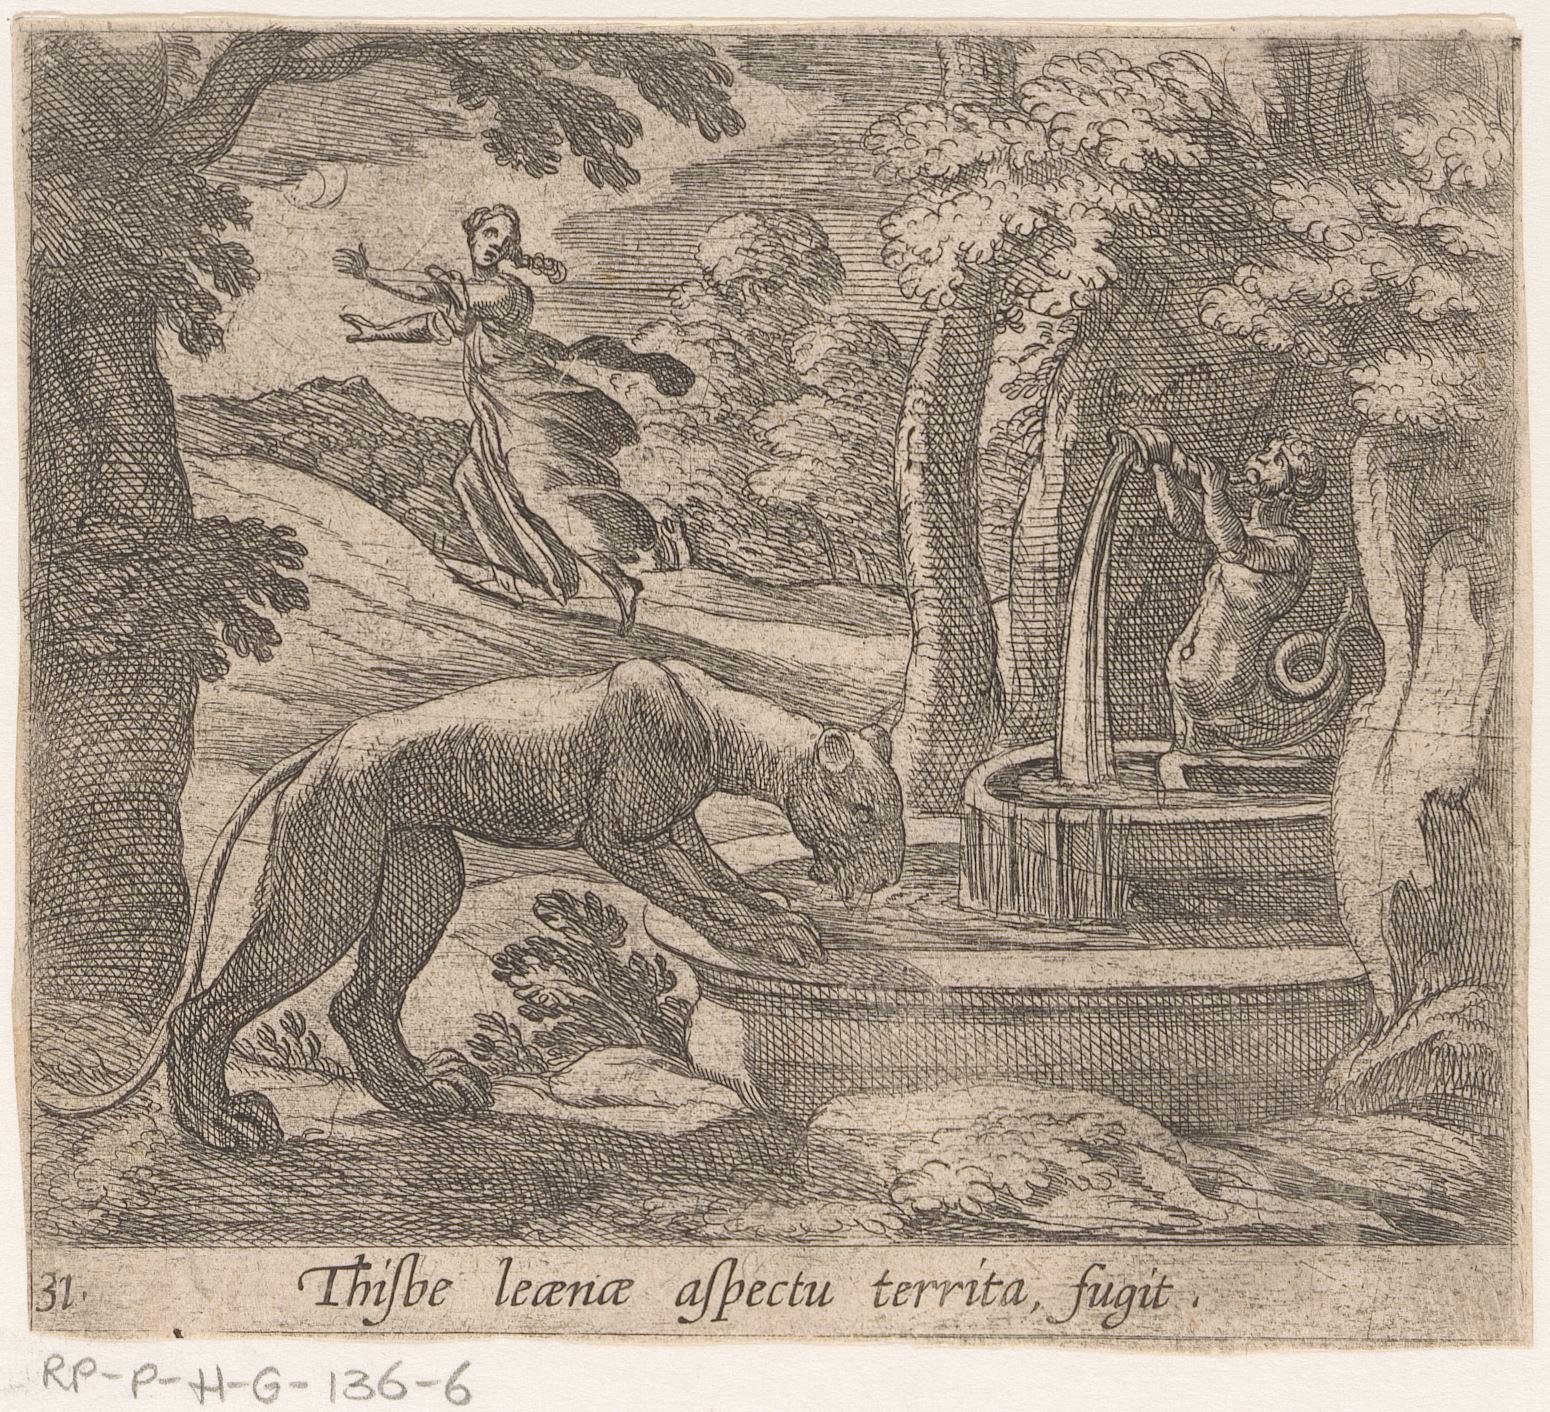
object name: print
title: Thisbe vlucht voor de leeuwin bij de bron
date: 1606-1638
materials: paper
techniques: etching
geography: italy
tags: thisbe, fleeing from a lioness, drops her veil (the scene may be situated near a fountain)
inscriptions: collector's mark: ‘Hinloopen’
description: Deze prent maakt deel uit van een reeks van 150 prenten (+ titelprent) met voorstellingen van de Metamorfosen van Ovidius.